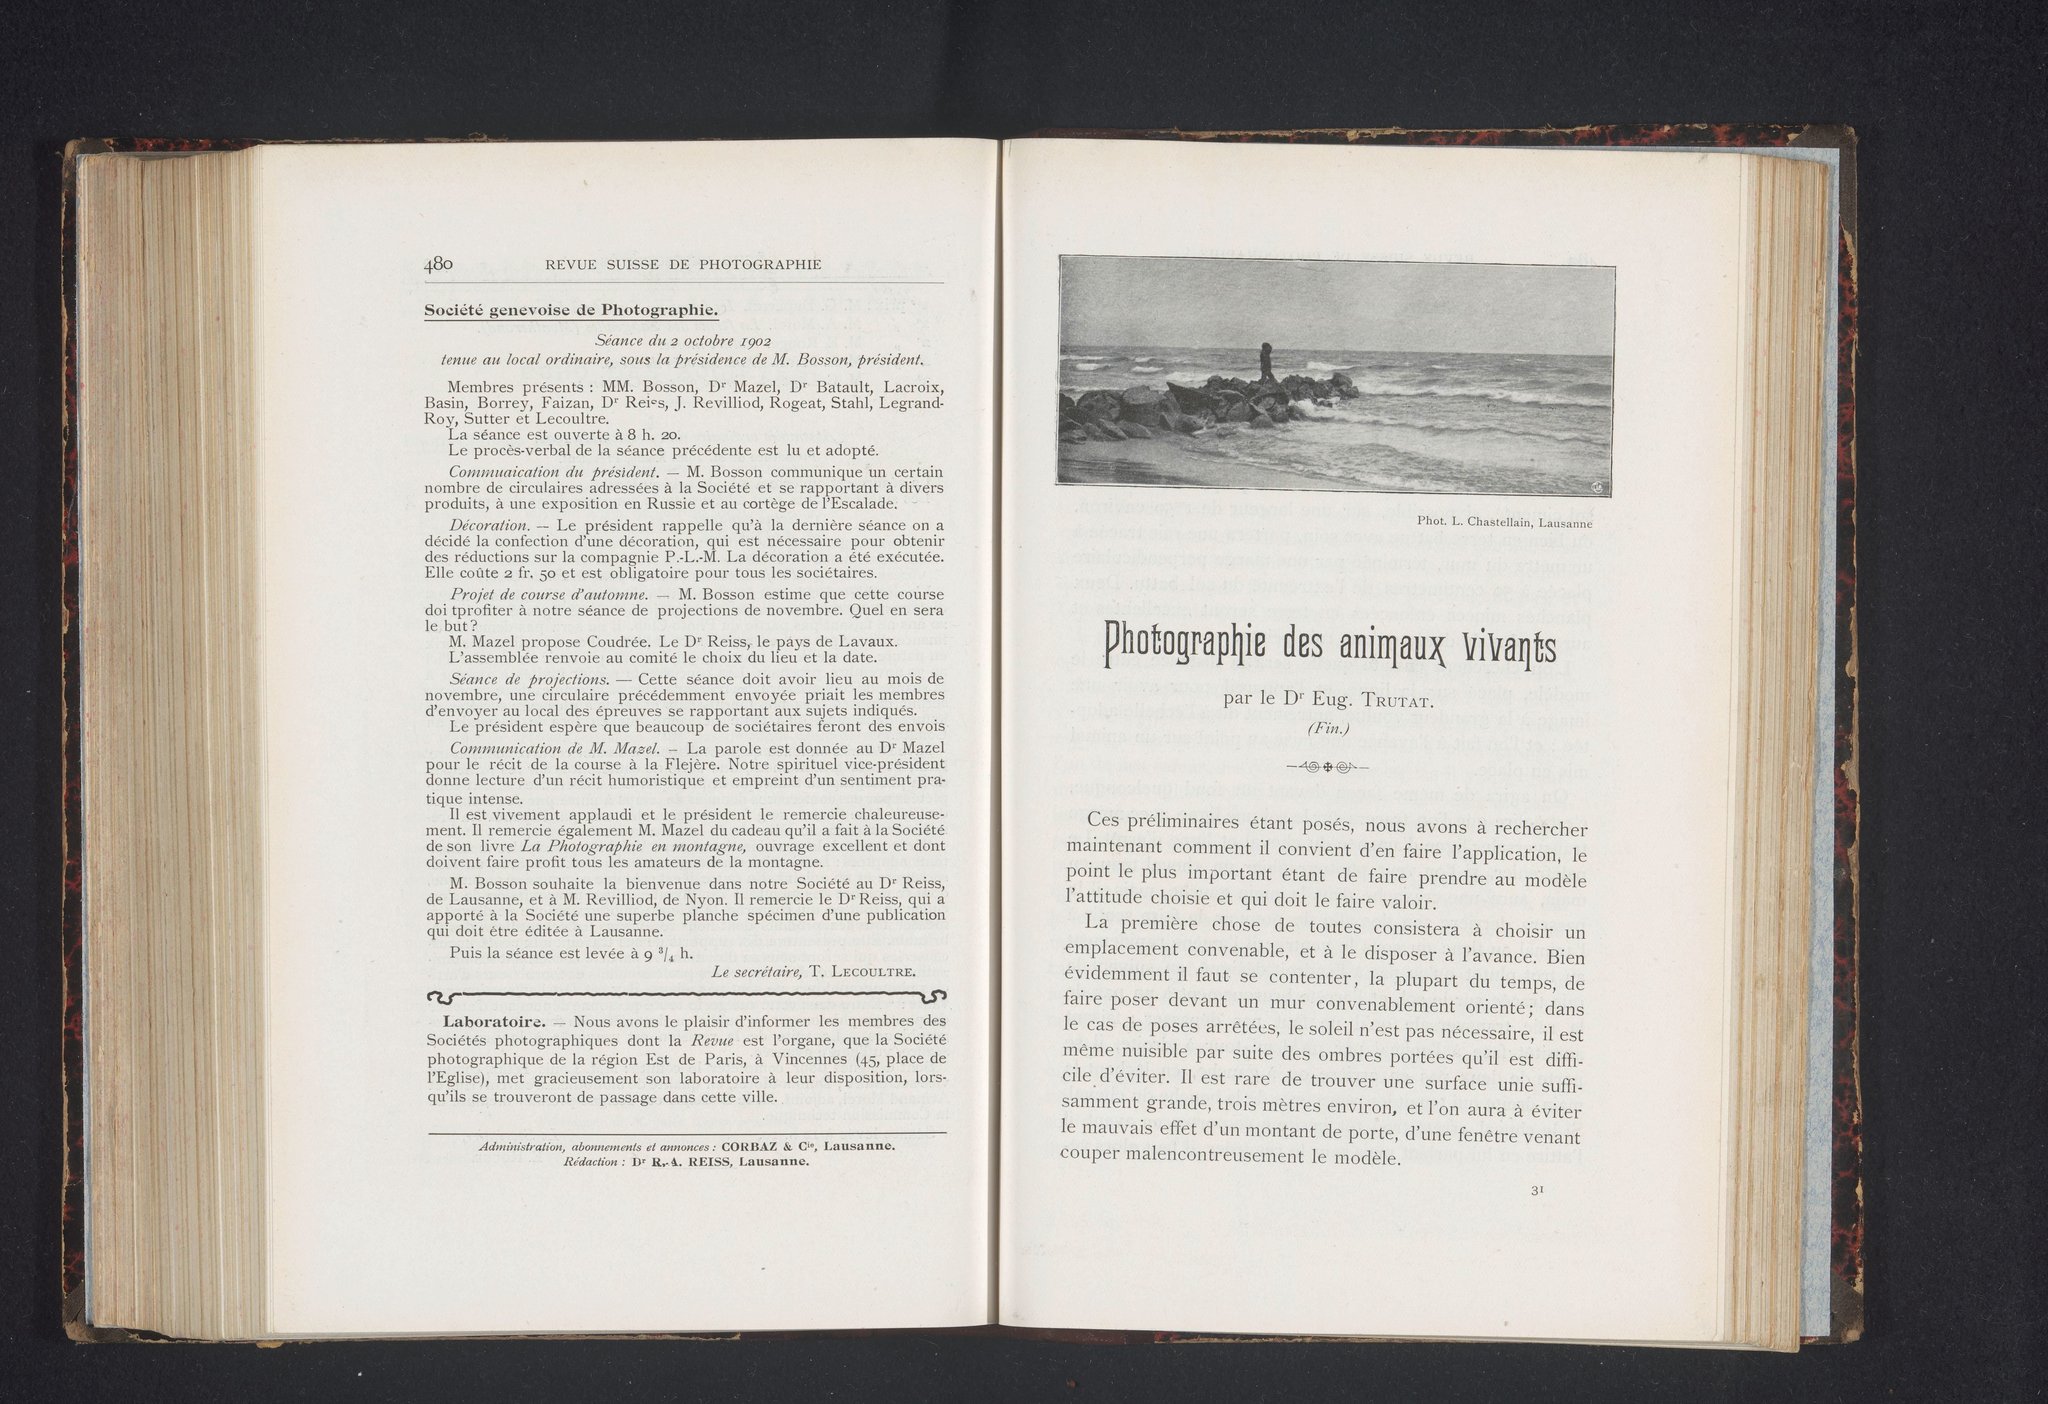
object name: page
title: Gezicht op zee met een figuur op de rotsen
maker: l. chastellain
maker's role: fotograaf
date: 1897-1902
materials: paper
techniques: autotype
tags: sea (seascape)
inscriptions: monogram: ‘C. Cie’